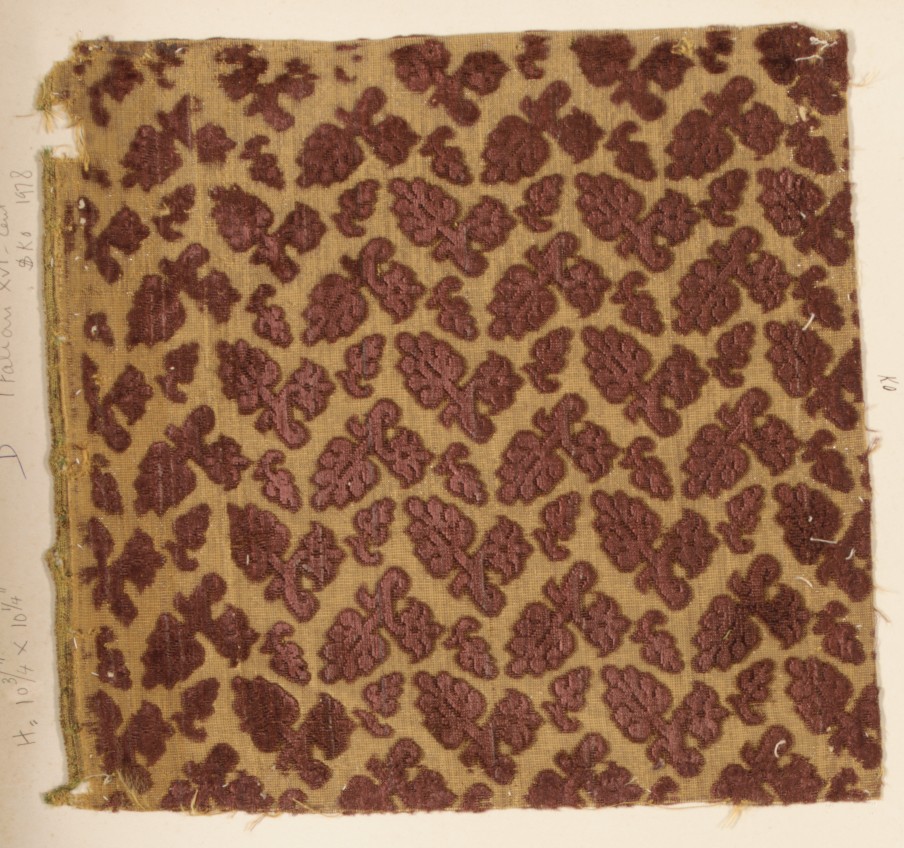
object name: fragment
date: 1501-1600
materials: metal thread, silk